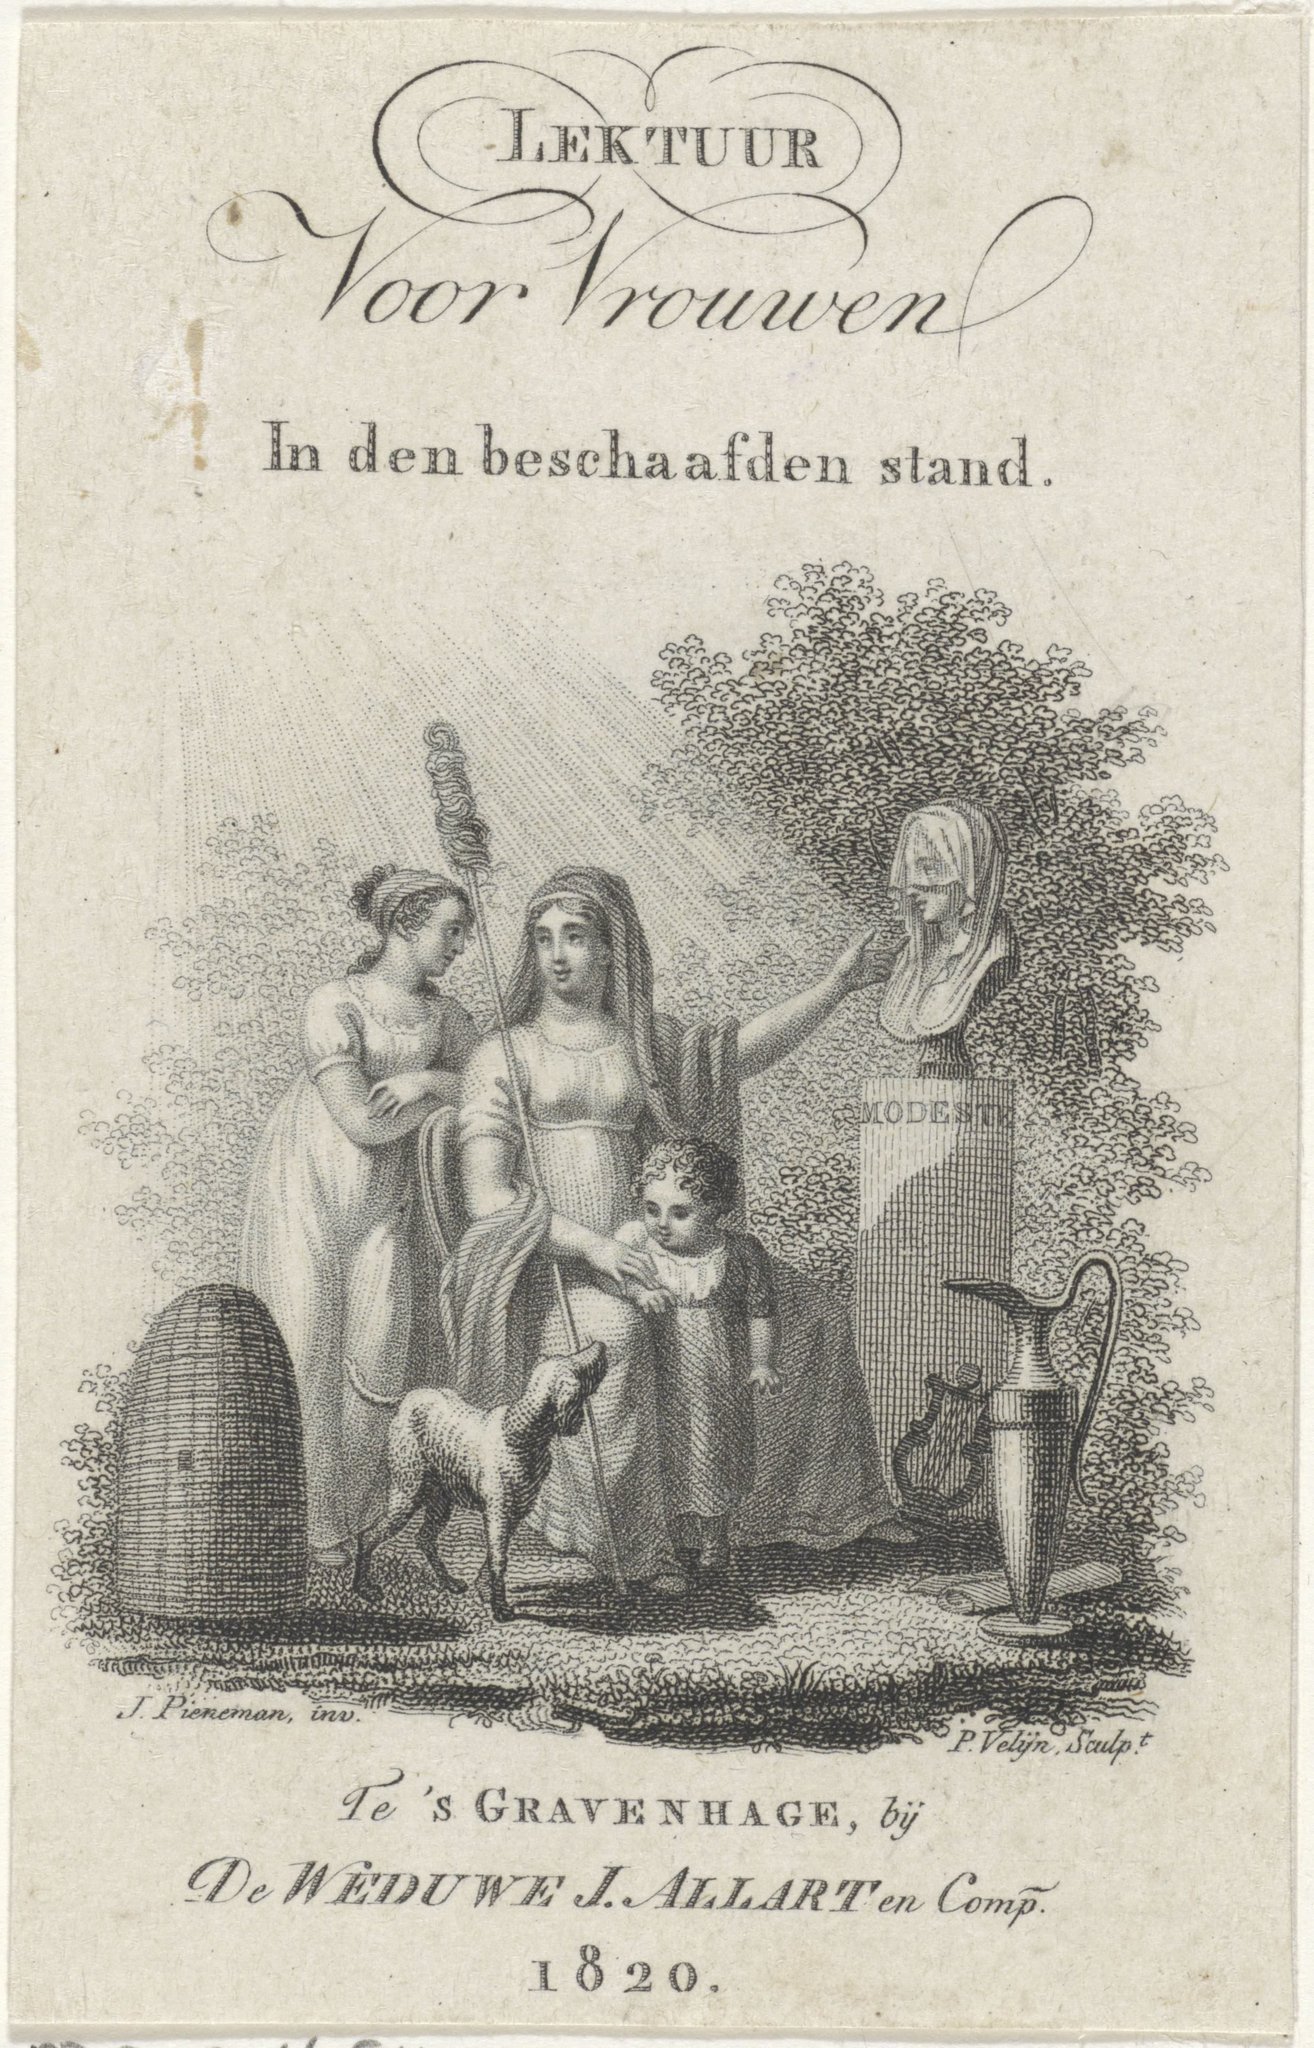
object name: print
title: Drie generaties vrouwen bij een buste van de gepersonifieerde bescheidenheid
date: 1820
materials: paper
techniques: etching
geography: the hague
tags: container of ceramics: jar, jug, pot, vase (+ variant), bee-hive, family relationships (first, second, third and fourth degree), generations, discretion, modesty; 'discretione', 'modestia' (ripa)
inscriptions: collector's mark: Lugt 2228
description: Drie generaties vrouwen bij een buste van een gesluierde vrouw op een sokkel, waarop de tekst: modeste. Rechts op de voorgrond een schenkkan en links een bijenkorf. Aan de voeten van de zittende vrouw een hond en tegen de sokkel van het beeld rust een lier. De vrouw heeft een spinrok vast.